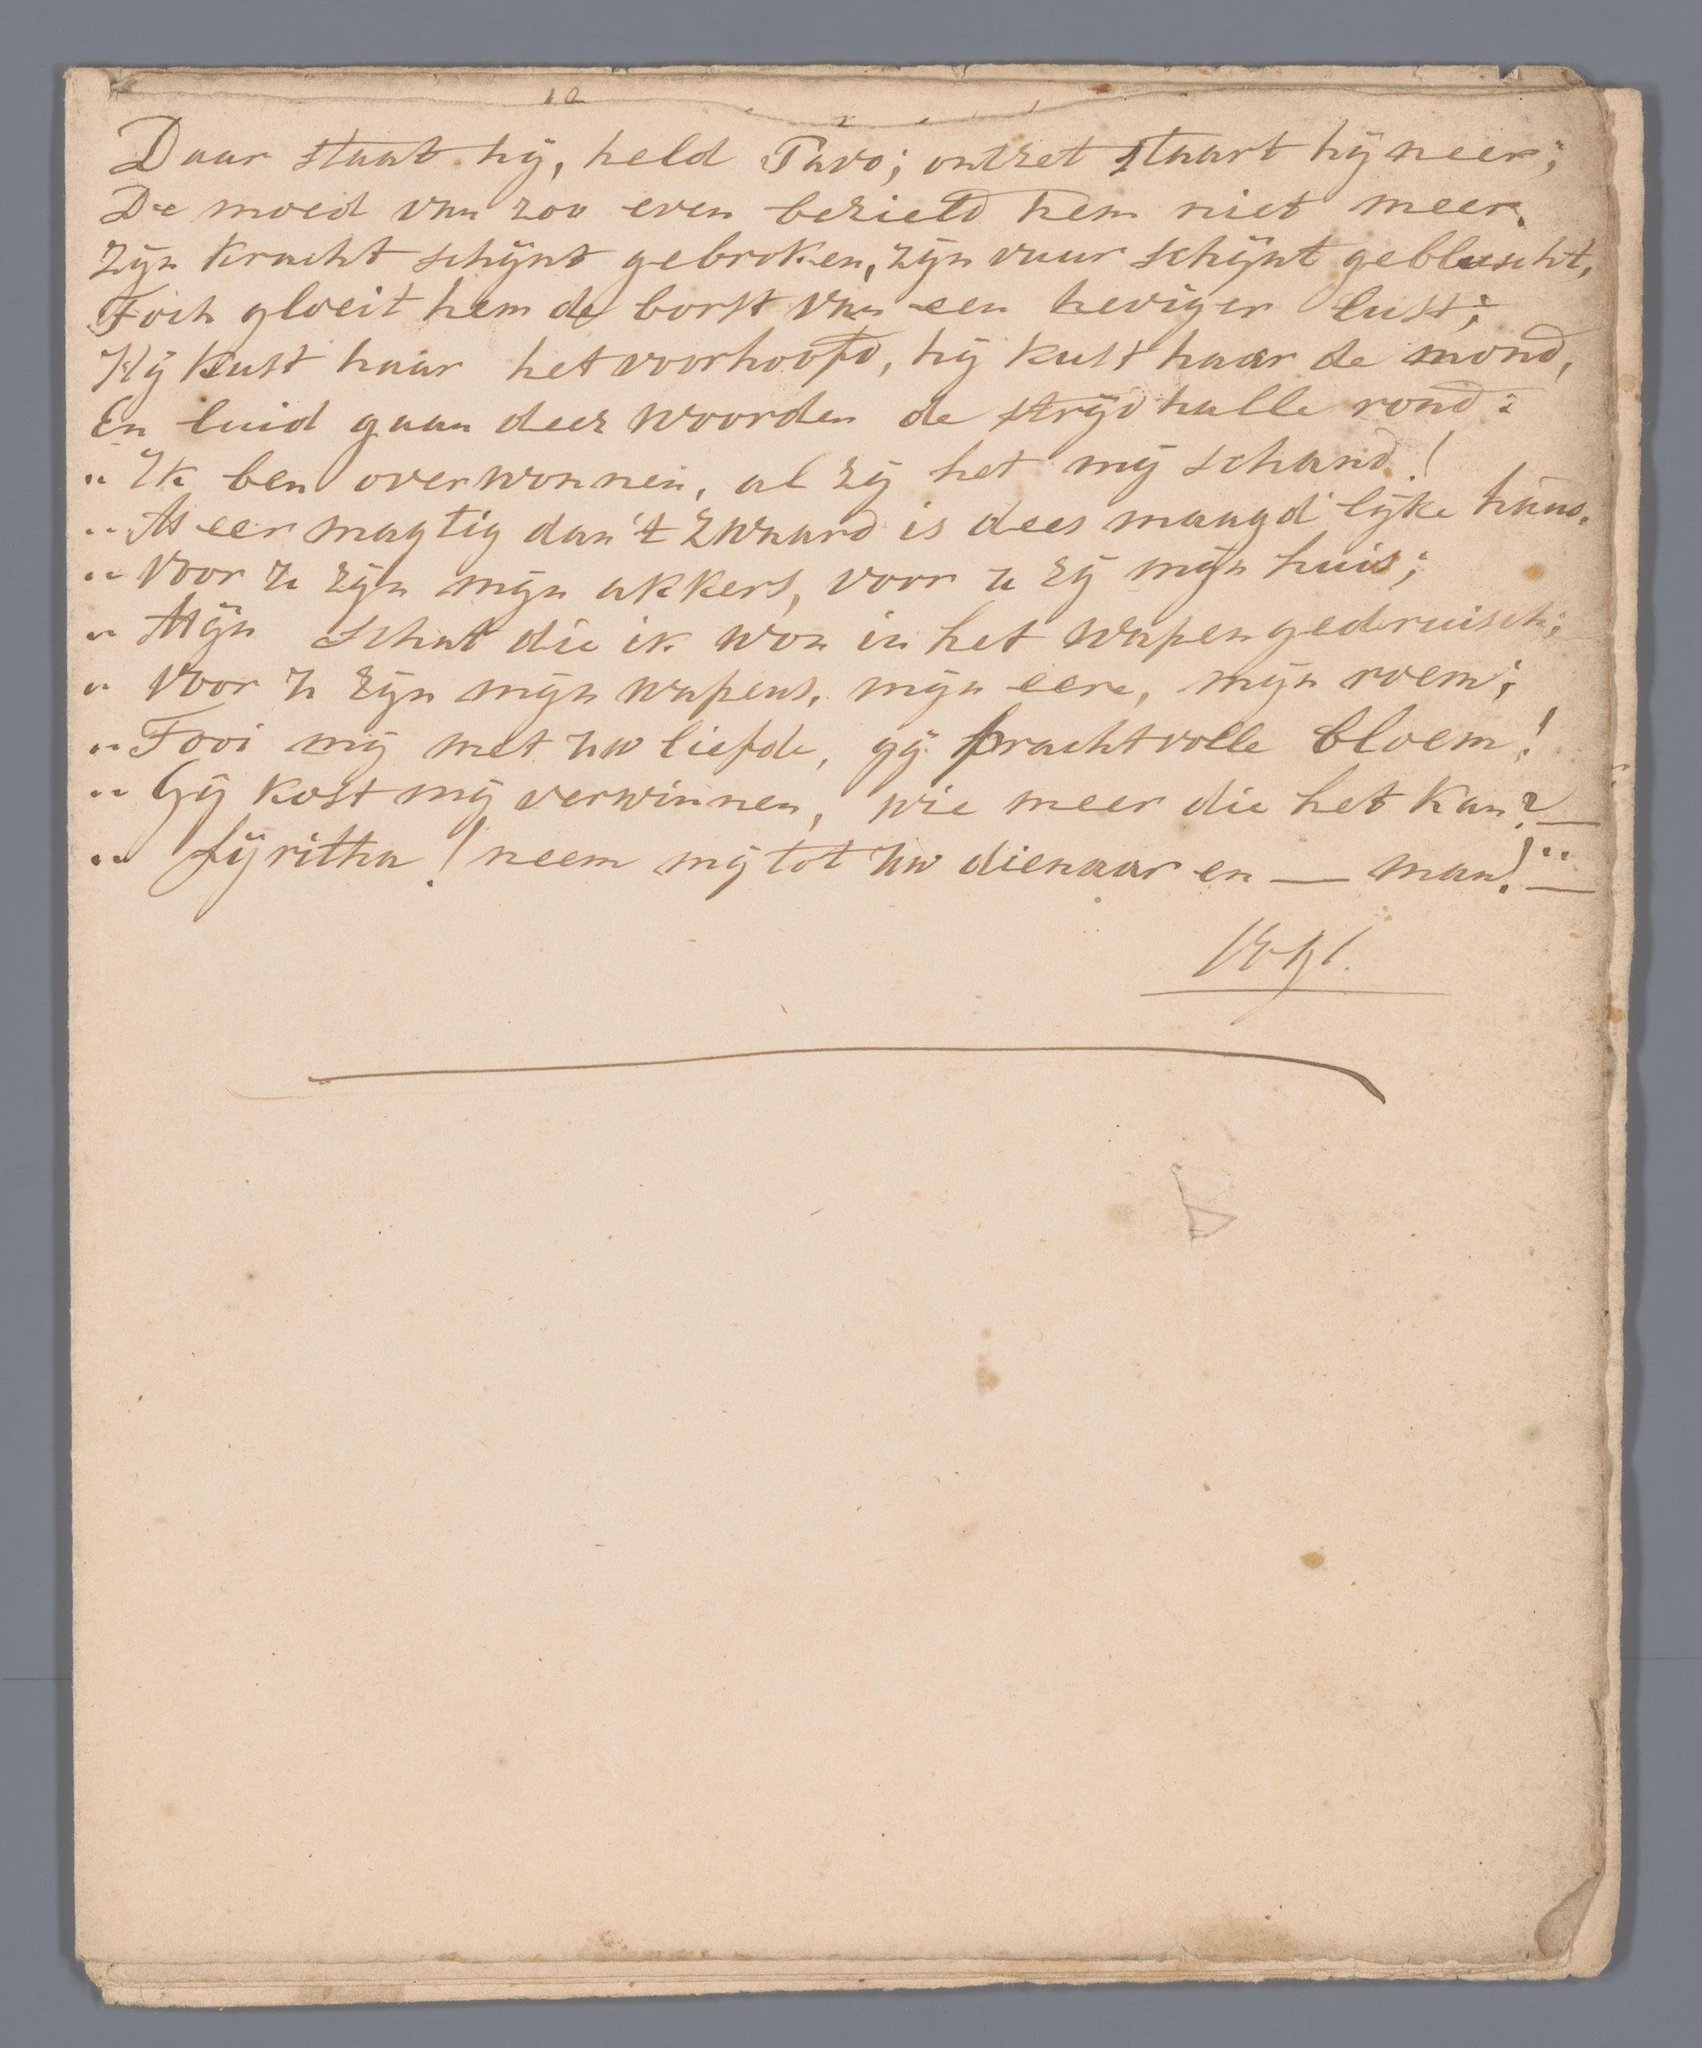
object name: document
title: Vrouwenmagt, Onno en Laura, Bij de Wieg van het kind eens armen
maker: klaas van staaveren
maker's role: schrijver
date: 1700-1800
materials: ink, paper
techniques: writing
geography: leimuiden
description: Manuscript van een aantal gedichten, 24 pp, deels dubbelgevouwen, waarvan 15 beschreven.